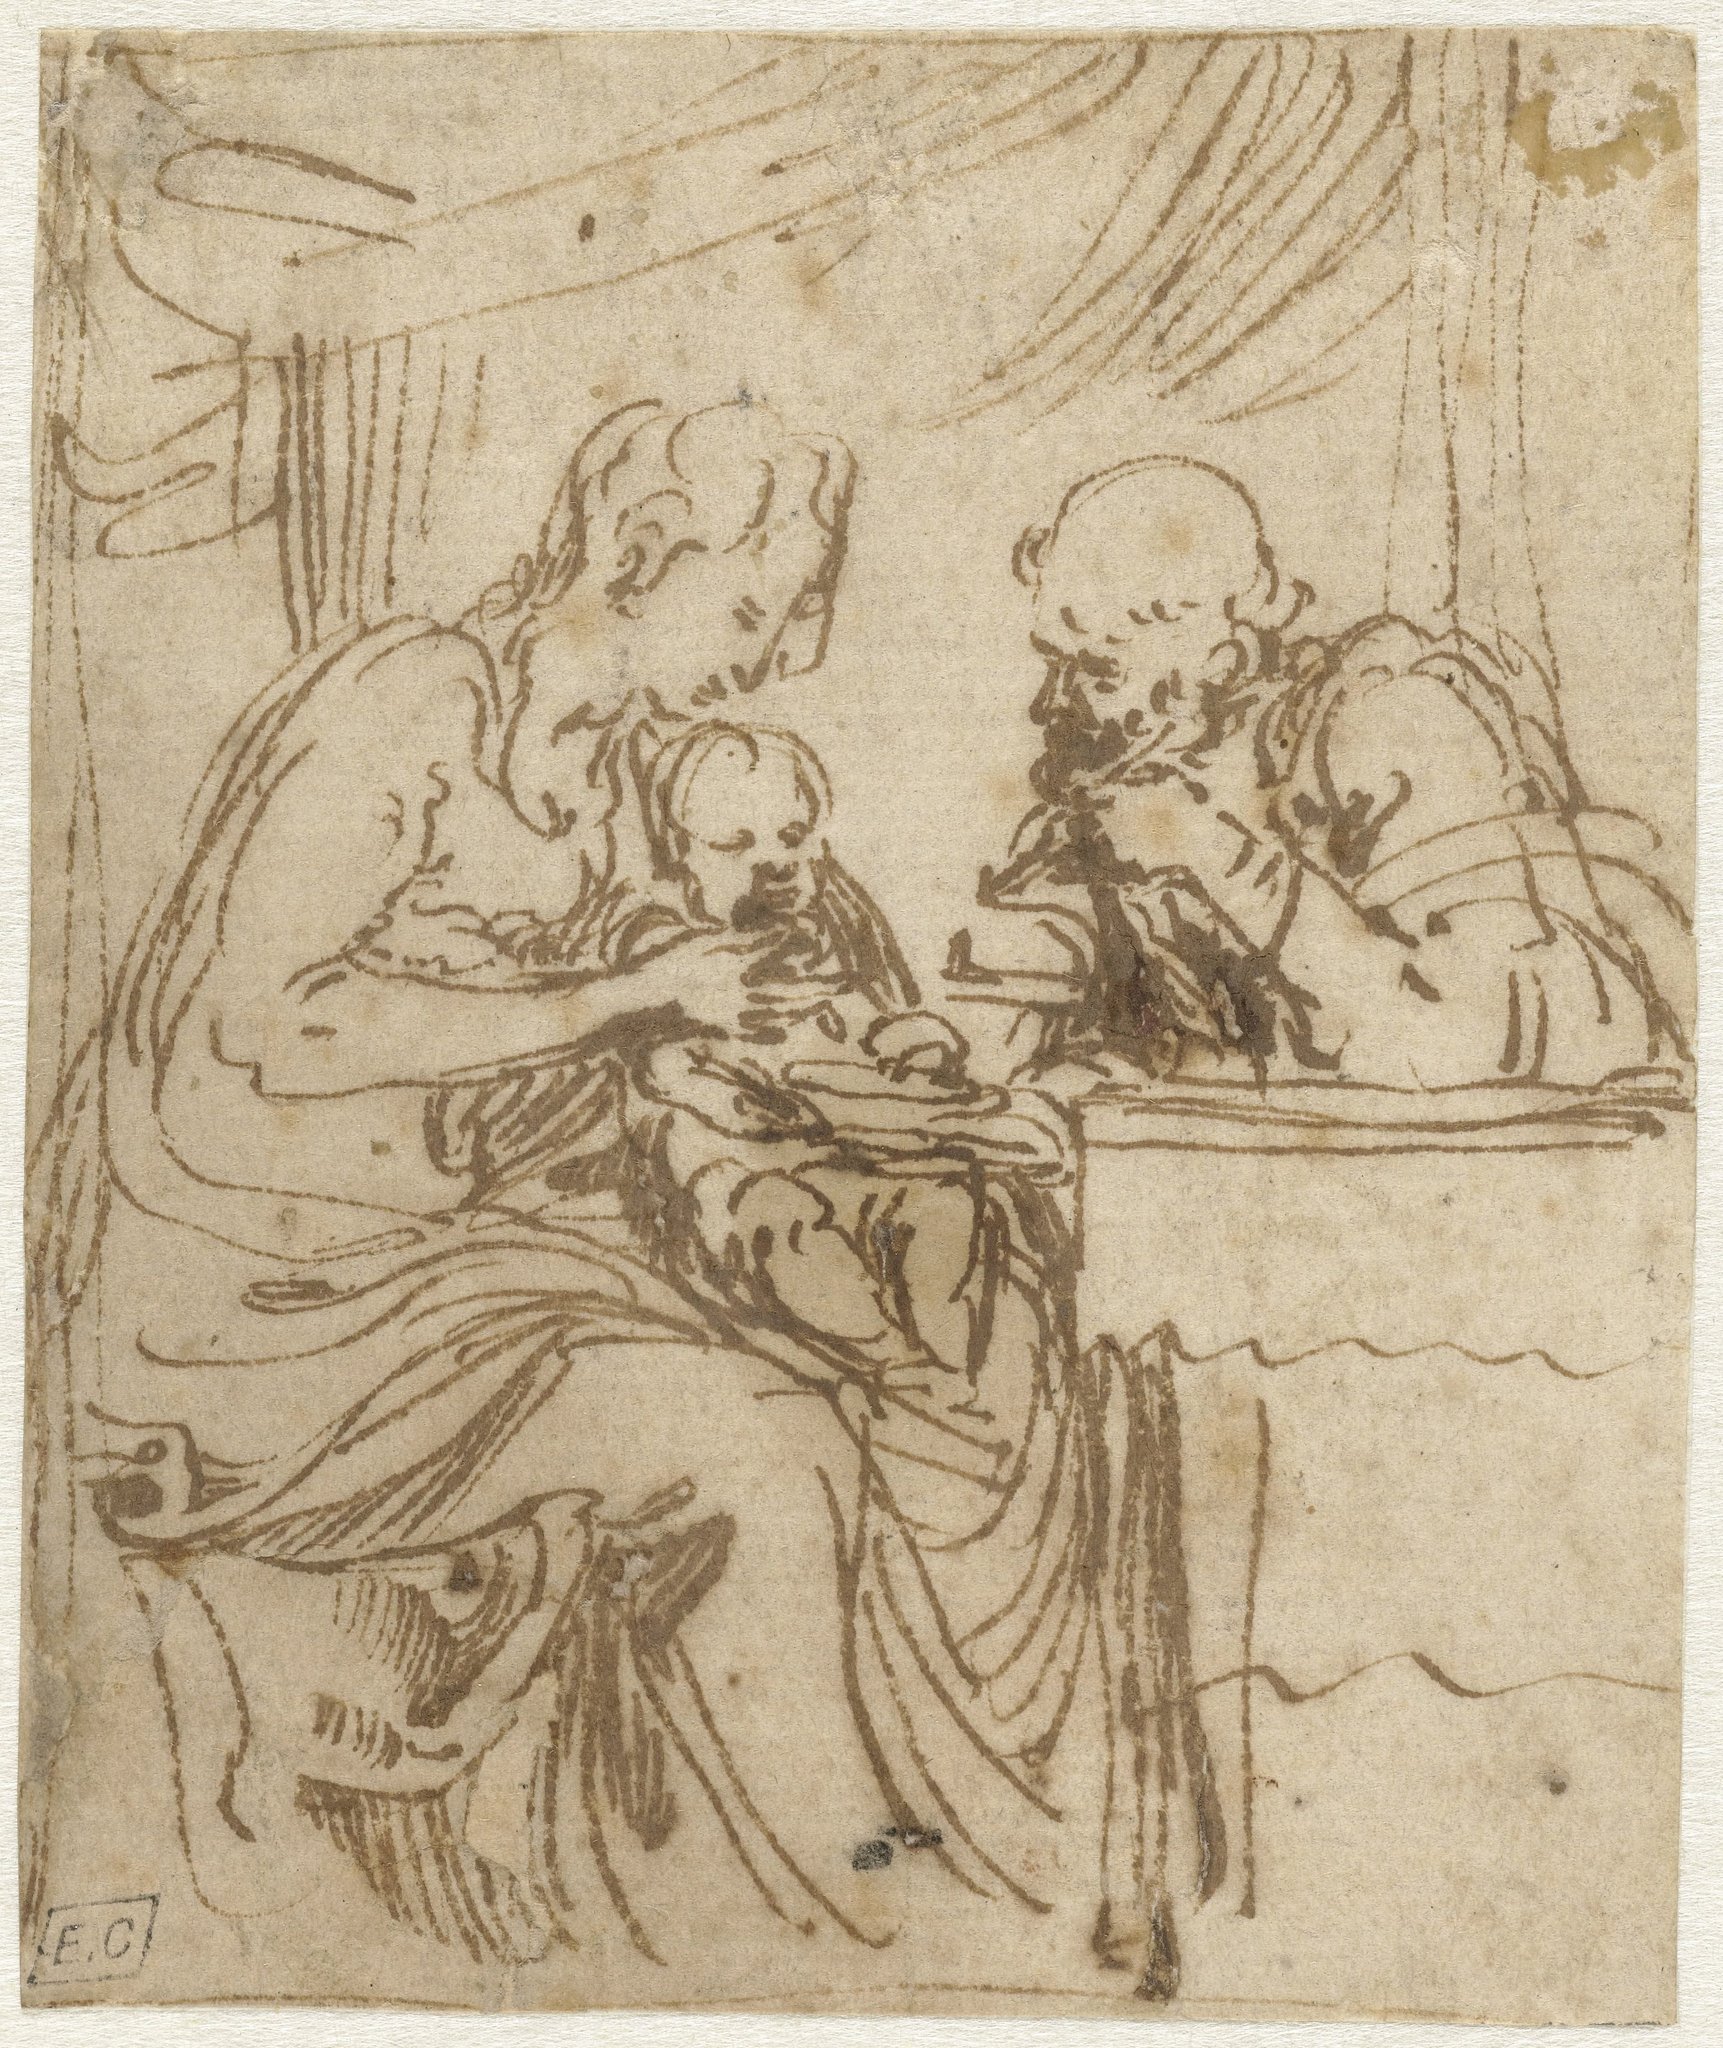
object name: drawing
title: De Heilige Familie bij de maaltijd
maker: giulio campi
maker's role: draughtsman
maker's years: 1502-1572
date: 1520-1572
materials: ink, paper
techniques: pen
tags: holy family, and derived representations